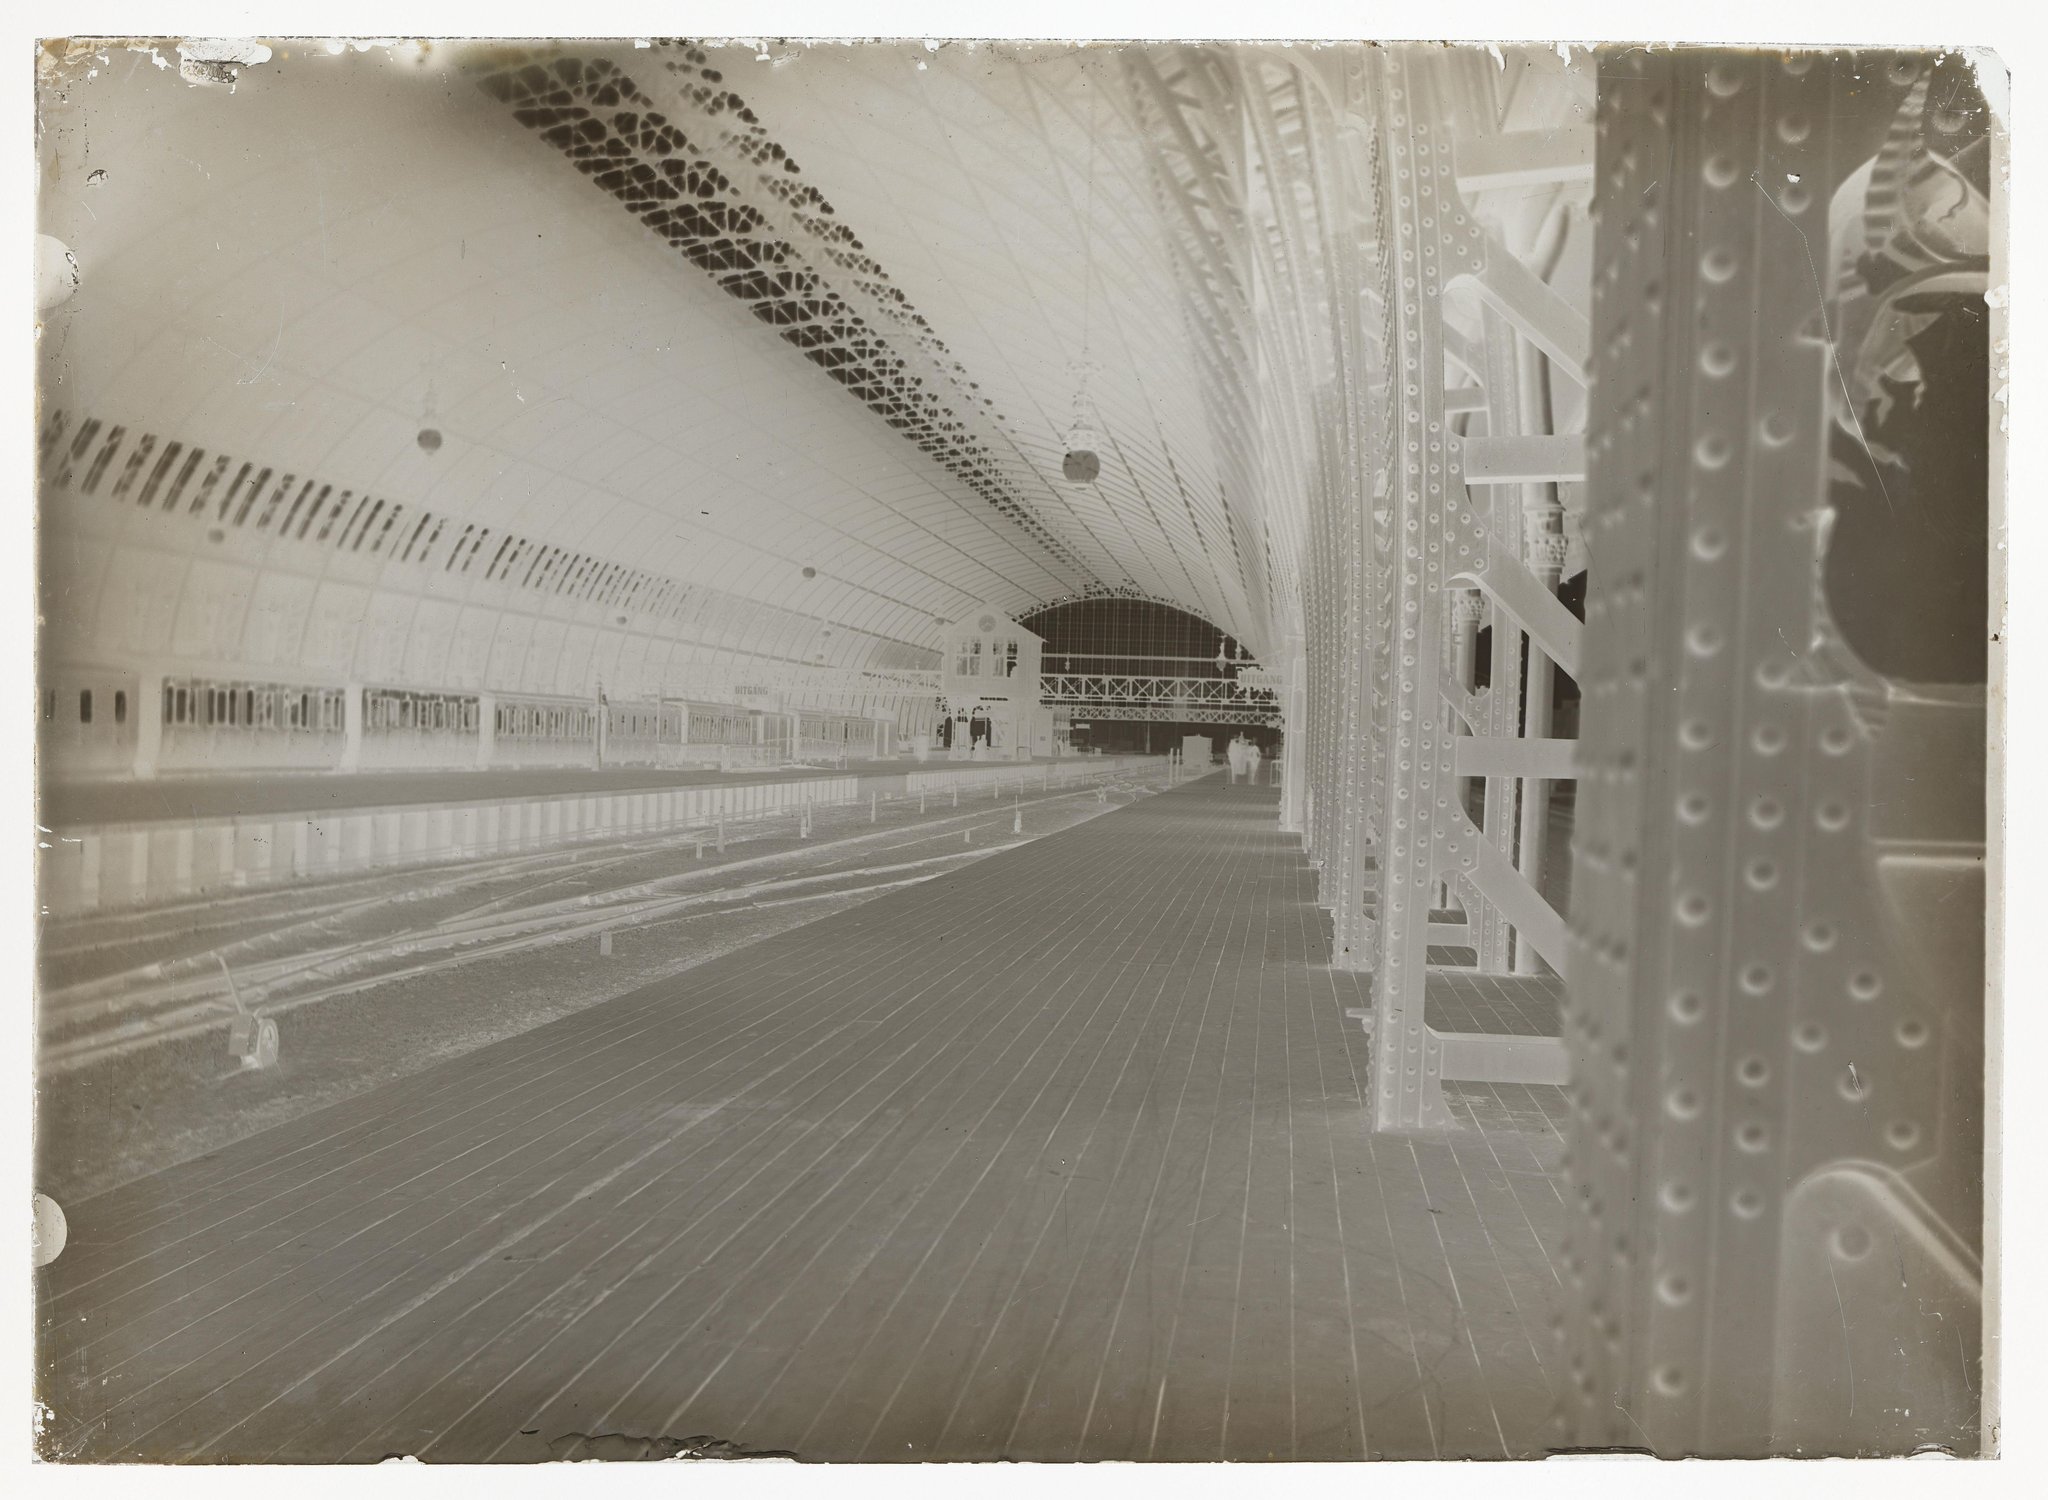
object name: glasnegatief, glasplaatnegatief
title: Overkapping Centraal Station in Amsterdam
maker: machiel gerrit george suyver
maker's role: fotograaf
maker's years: 1872-1933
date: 1890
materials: glass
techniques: gelatin glass negative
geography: amsterdam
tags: shipyard, shipdock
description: De foto toont de overkapping van het Centraal Station in Amsterdam dat in 1889 in gebruik is genomen.